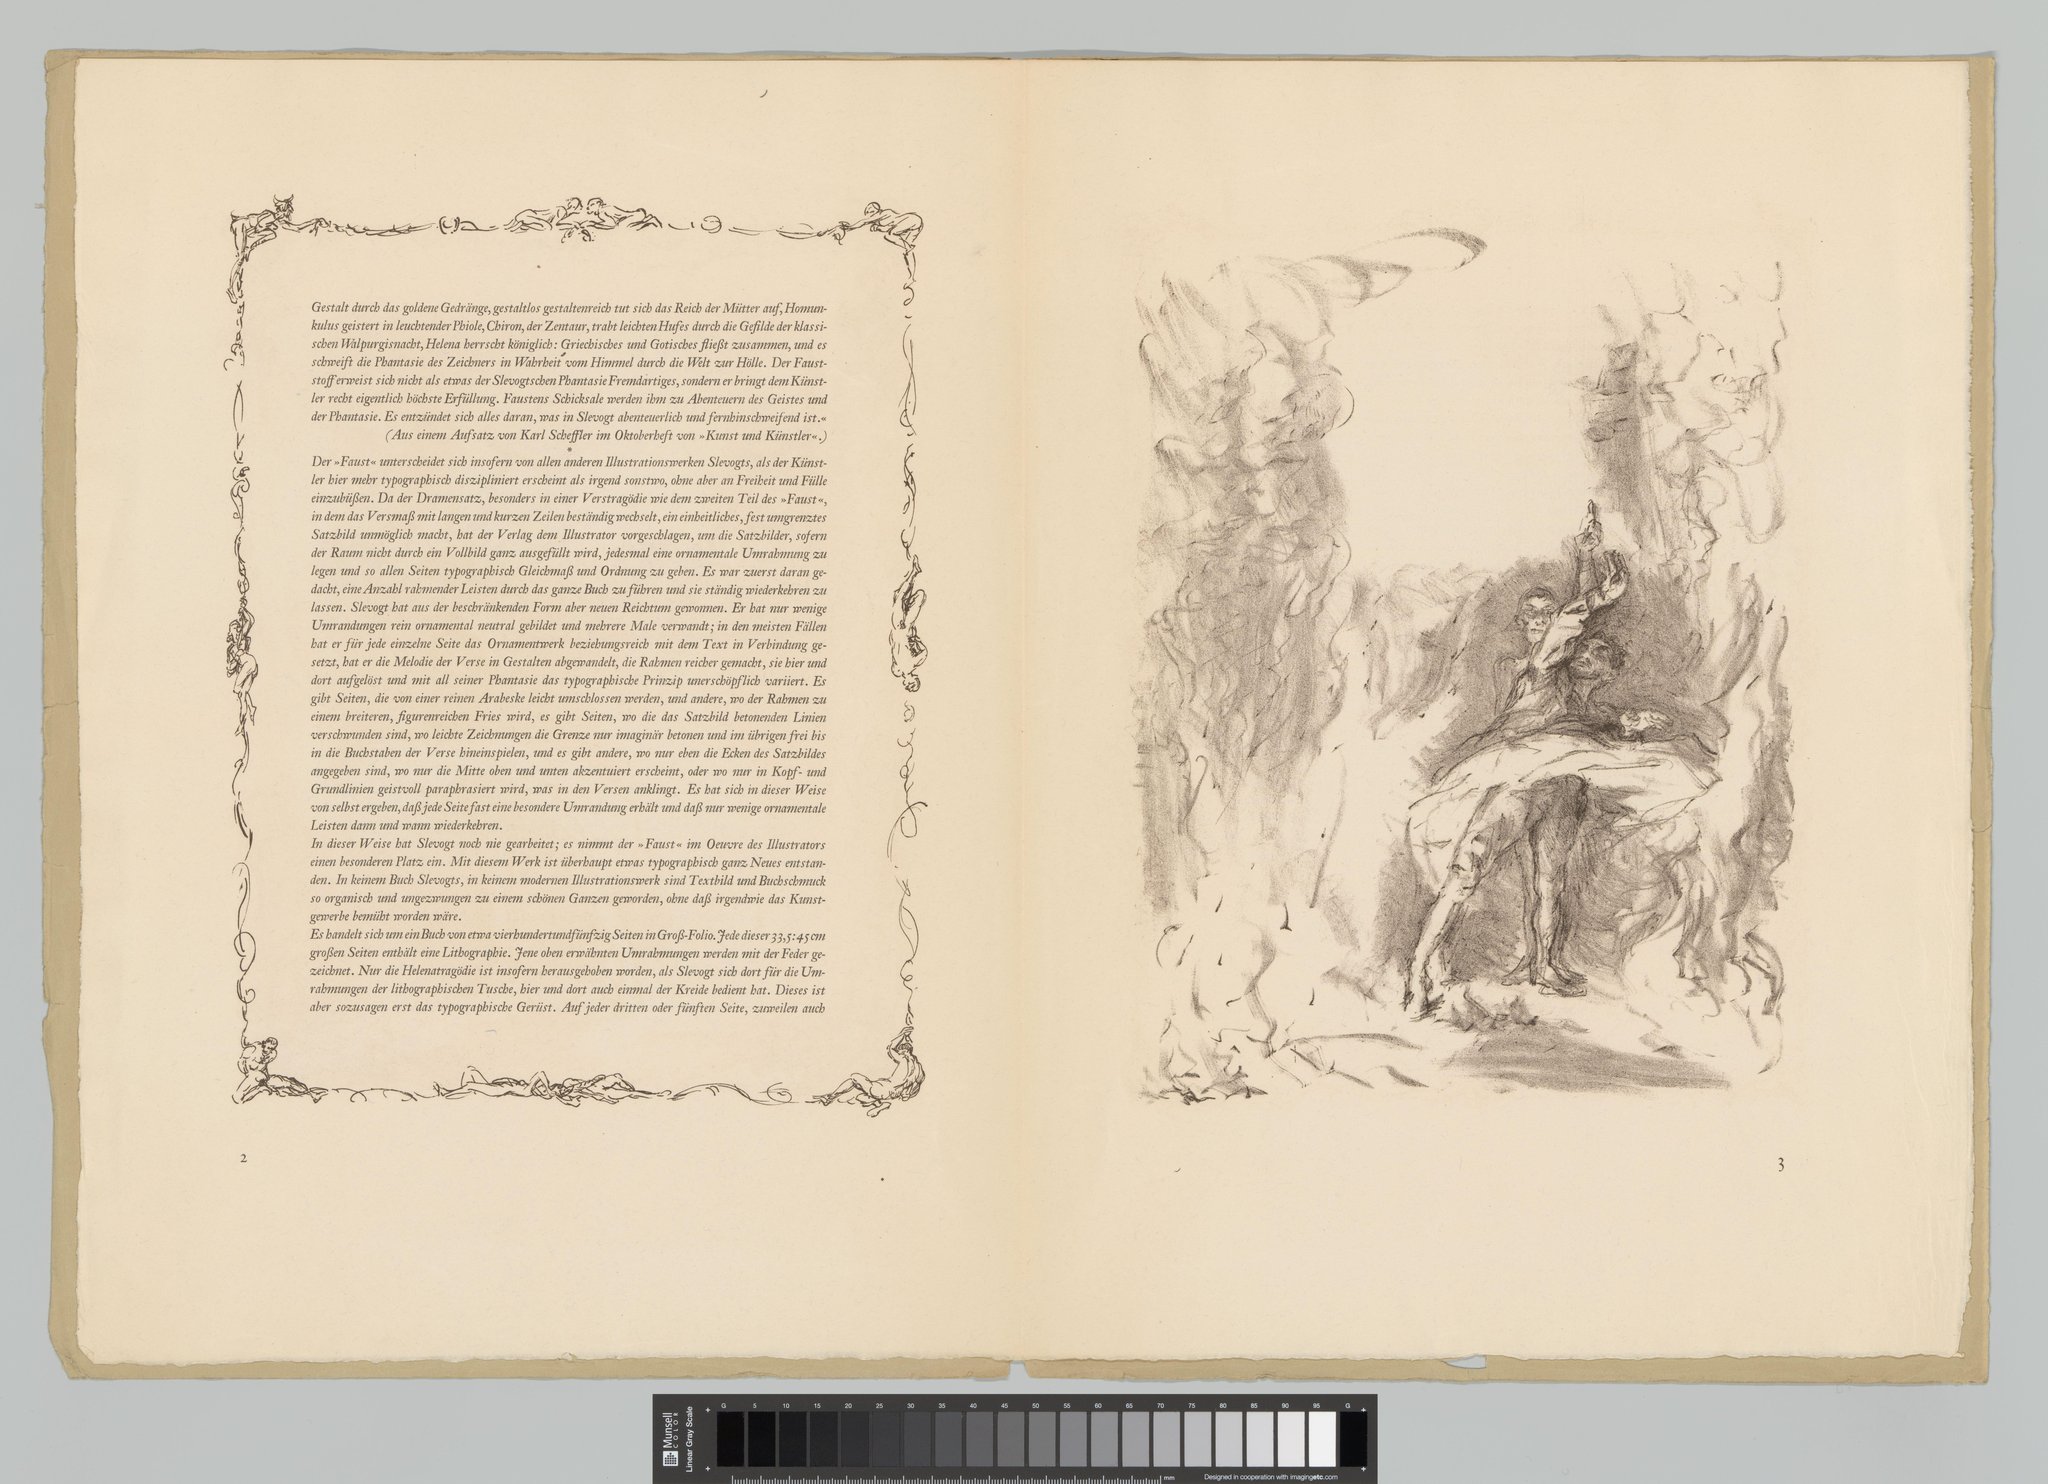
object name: print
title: Faust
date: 1925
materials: paper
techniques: letterpress printing, lithograph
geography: berlin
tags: faust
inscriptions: date